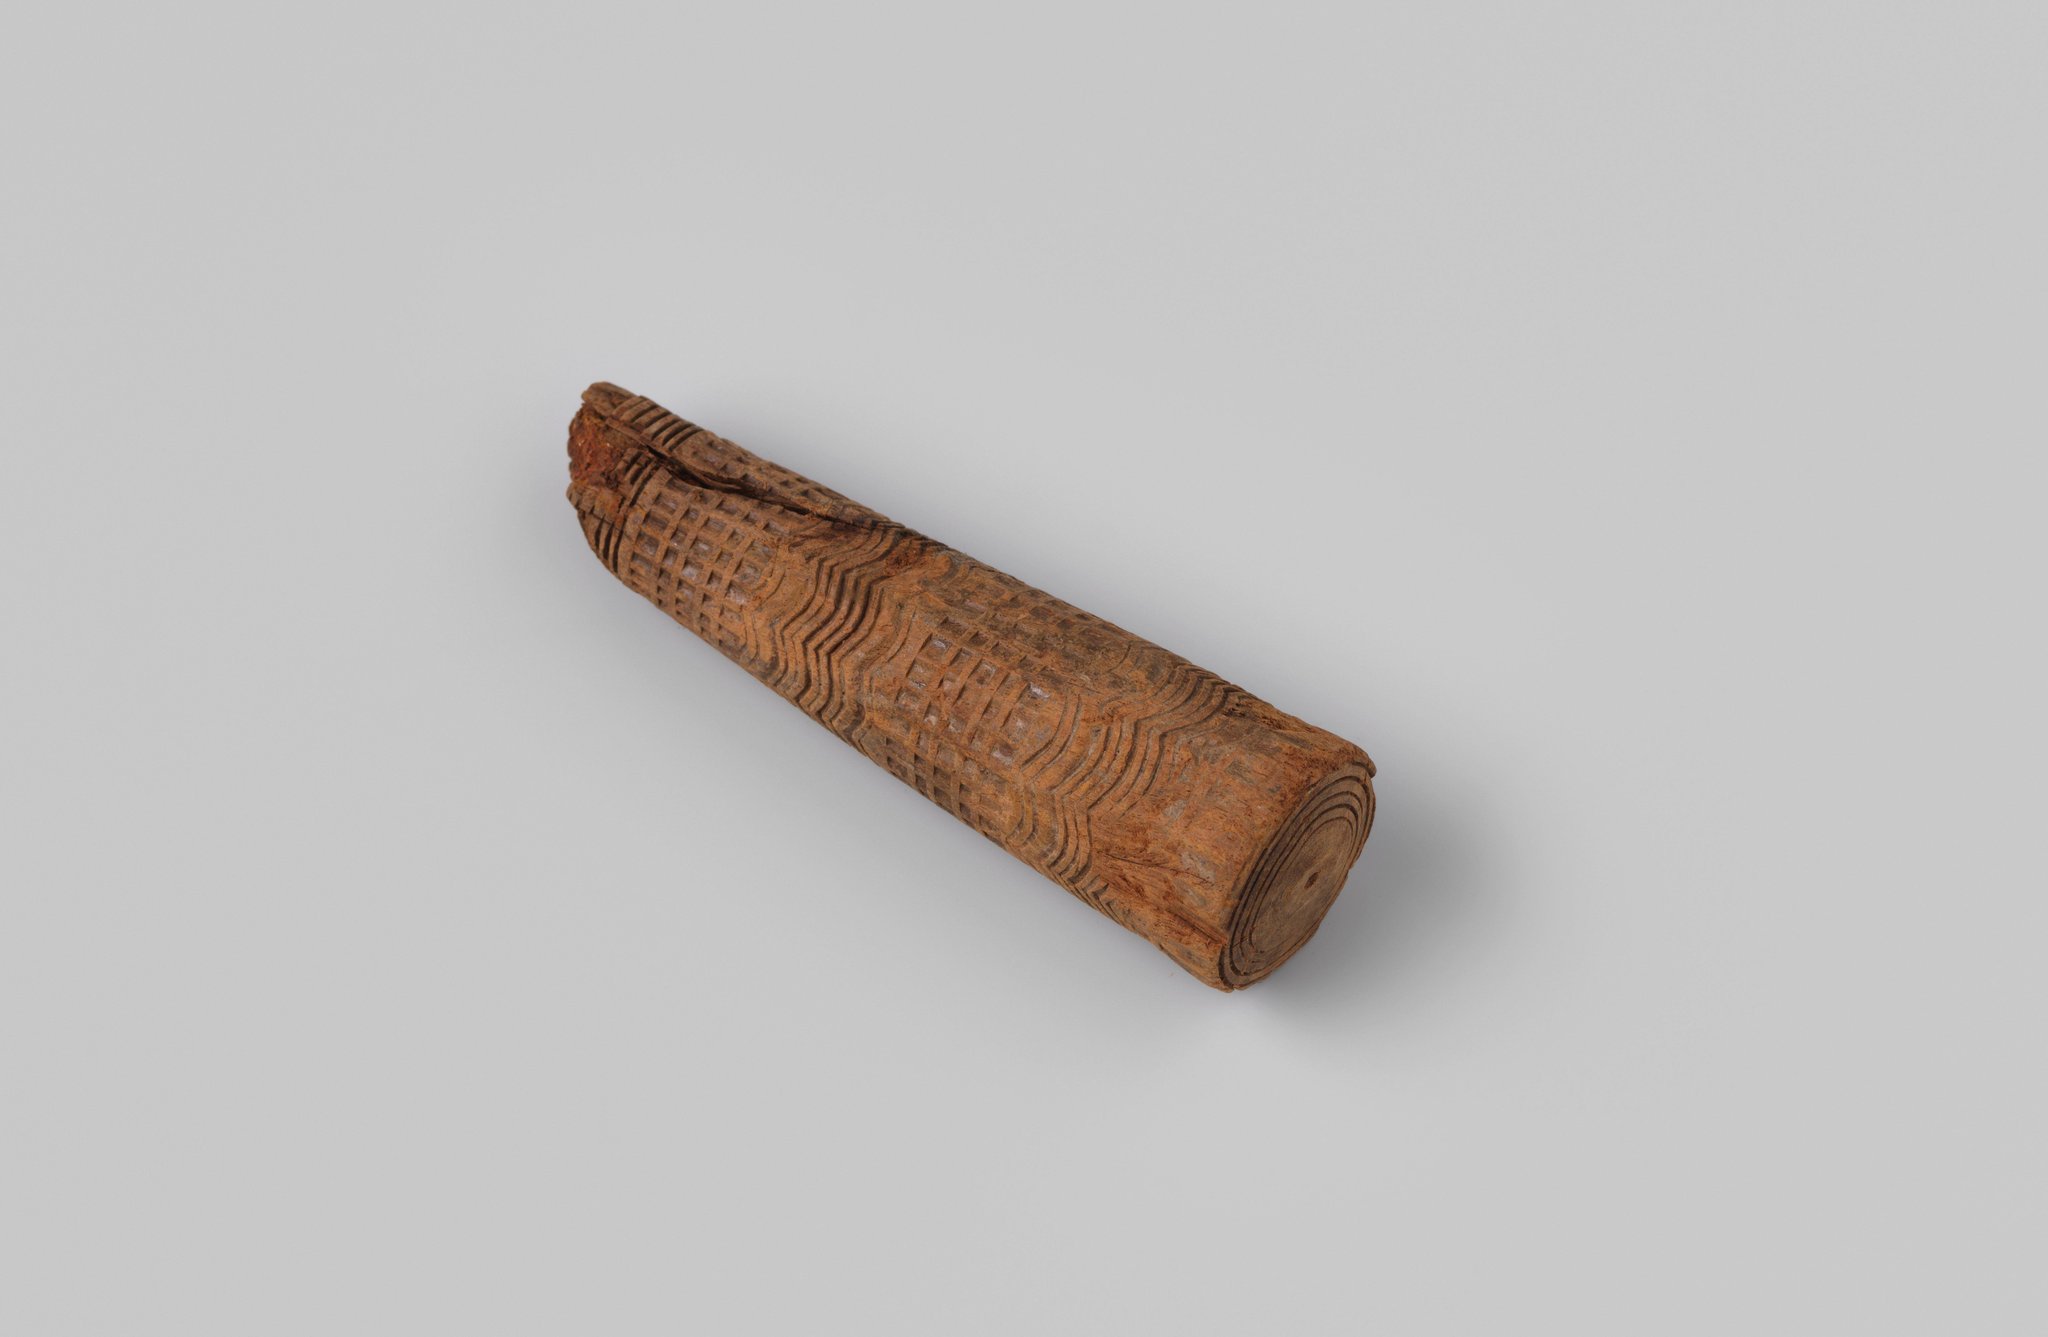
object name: knife handle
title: Messenheft uit het wrak van de Oost-Indiëvaarder Hollandia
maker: Anonymous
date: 1700-1743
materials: wood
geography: netherlands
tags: verenigde oostindische compagnie, hollandia (schip), annet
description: Knife, handle, cylindrical: tapering; id. NG 1979-403H, ferrules id. NG 1980-27H426.